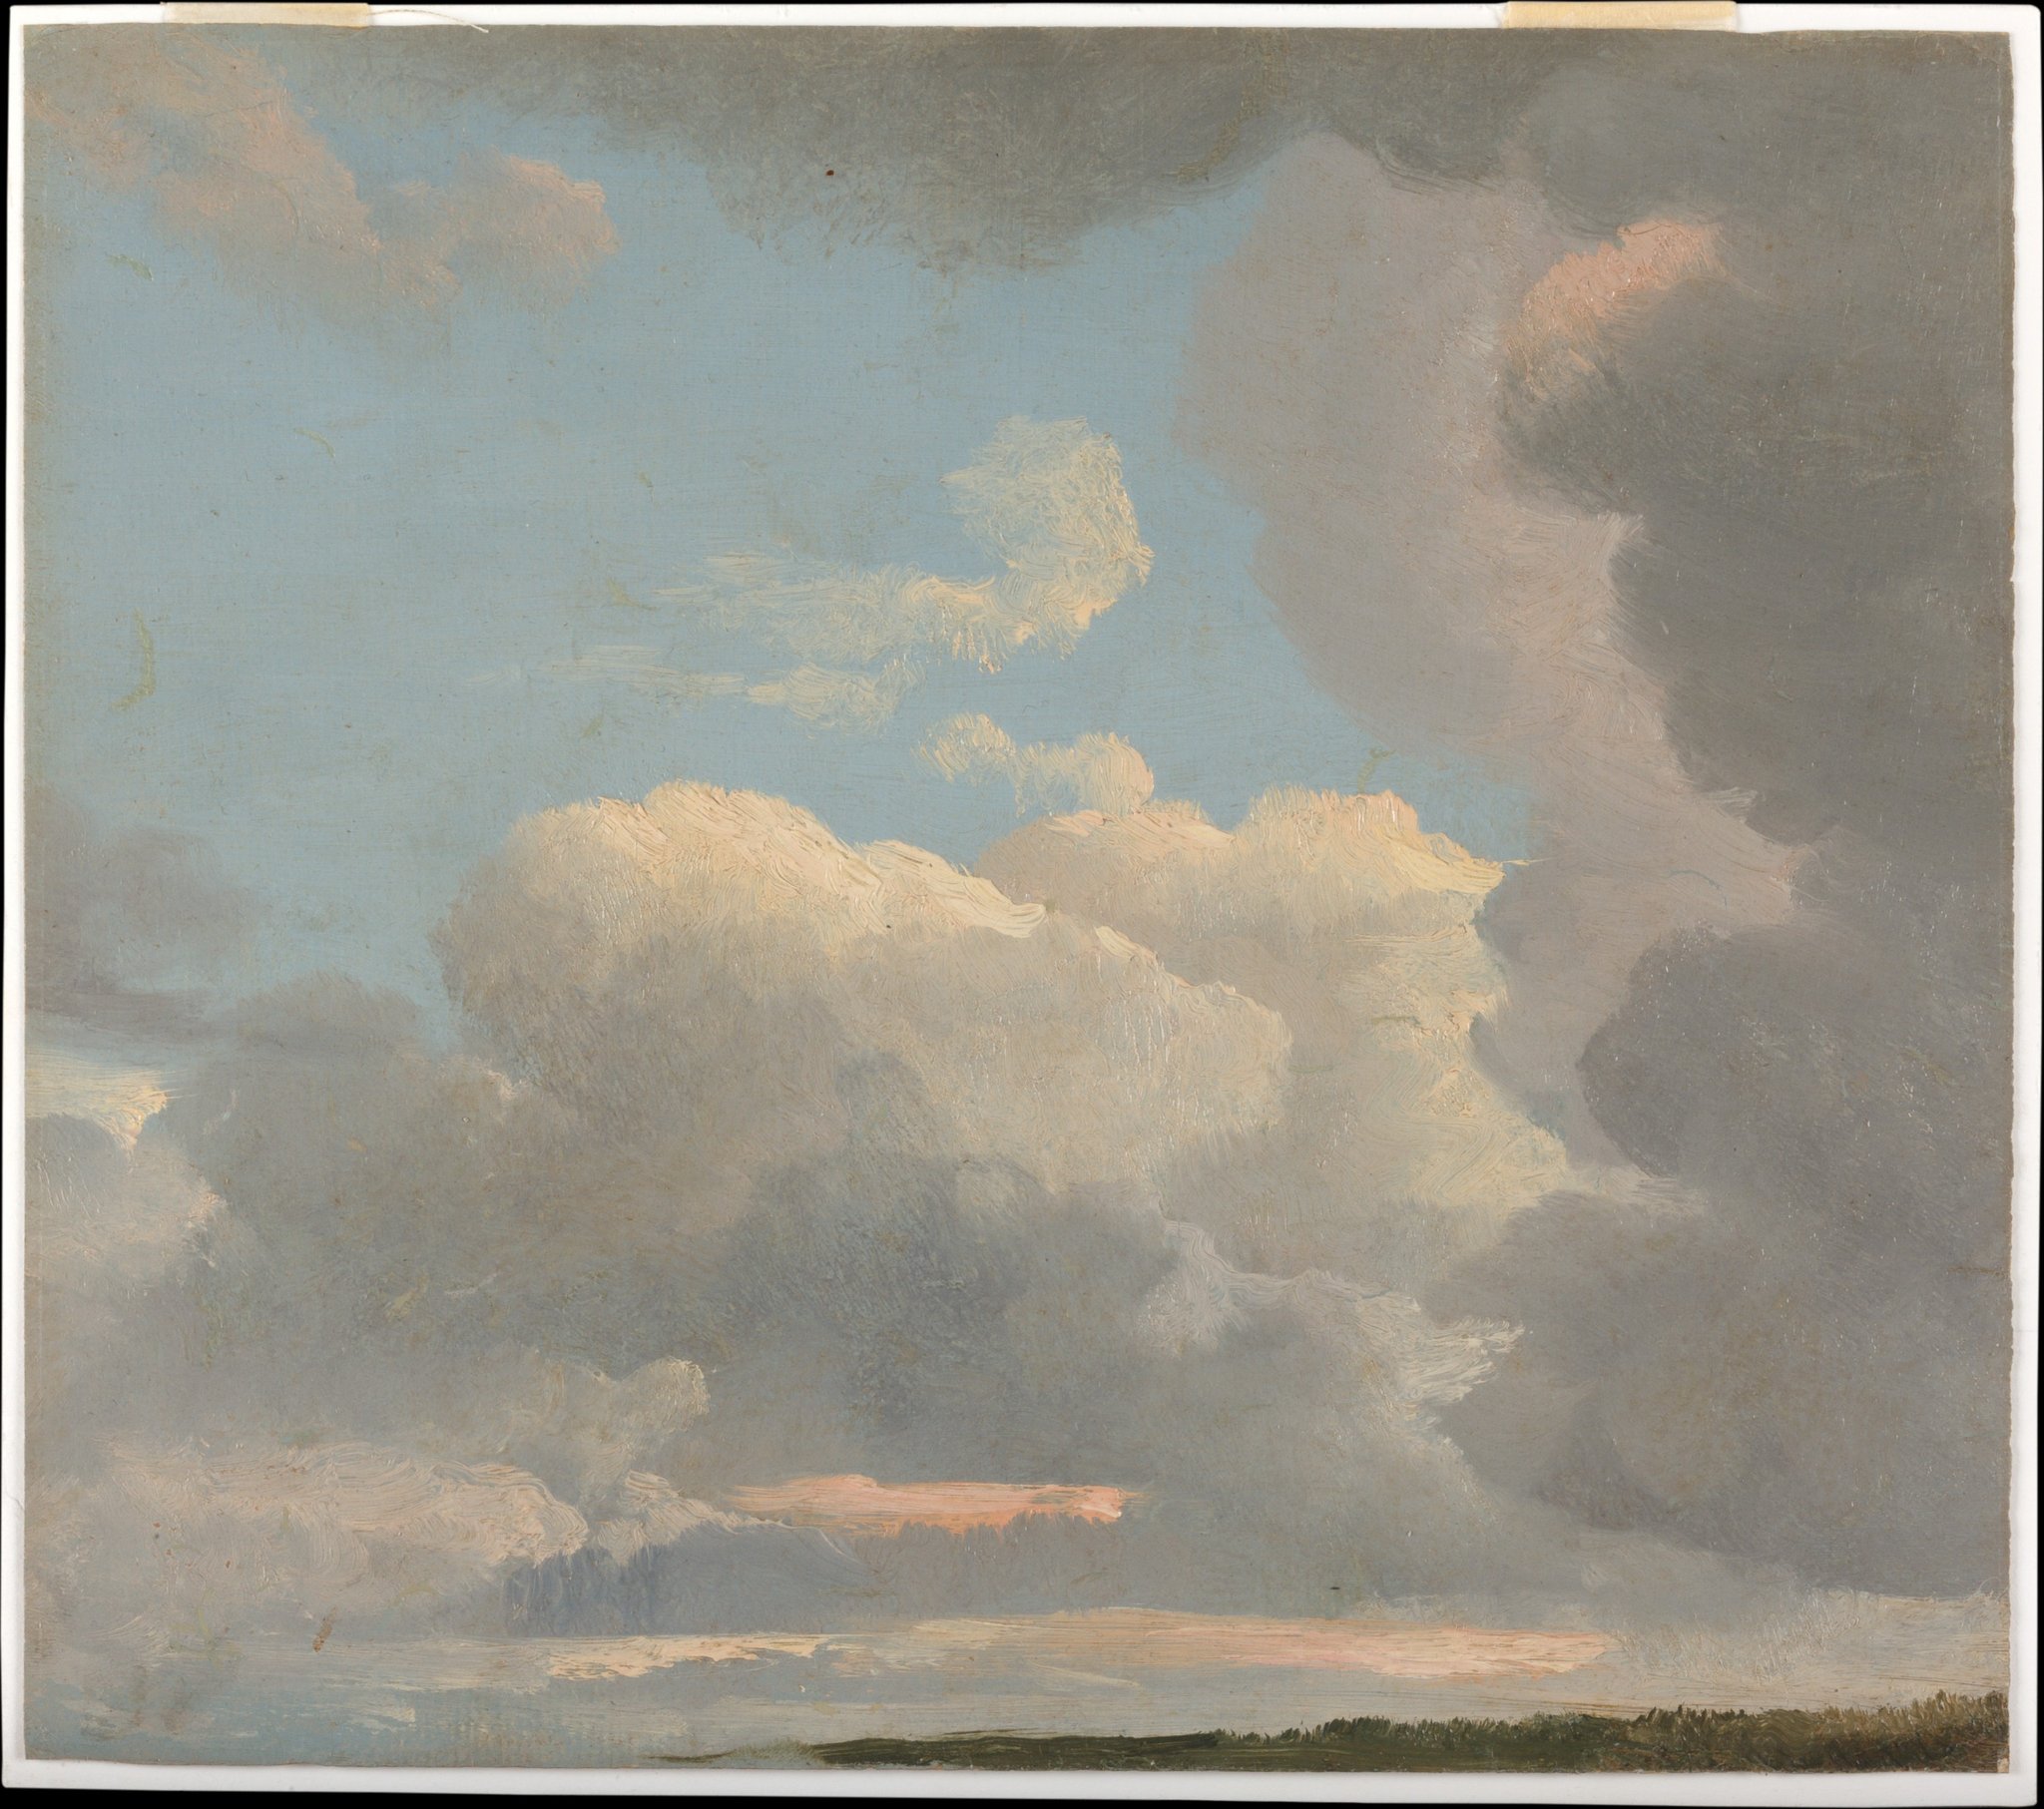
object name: painting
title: Cloud Study (Early Evening)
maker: simon denis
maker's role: artist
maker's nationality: flemish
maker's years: 1755-1813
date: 1786-1806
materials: oil, paper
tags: sky,clouds